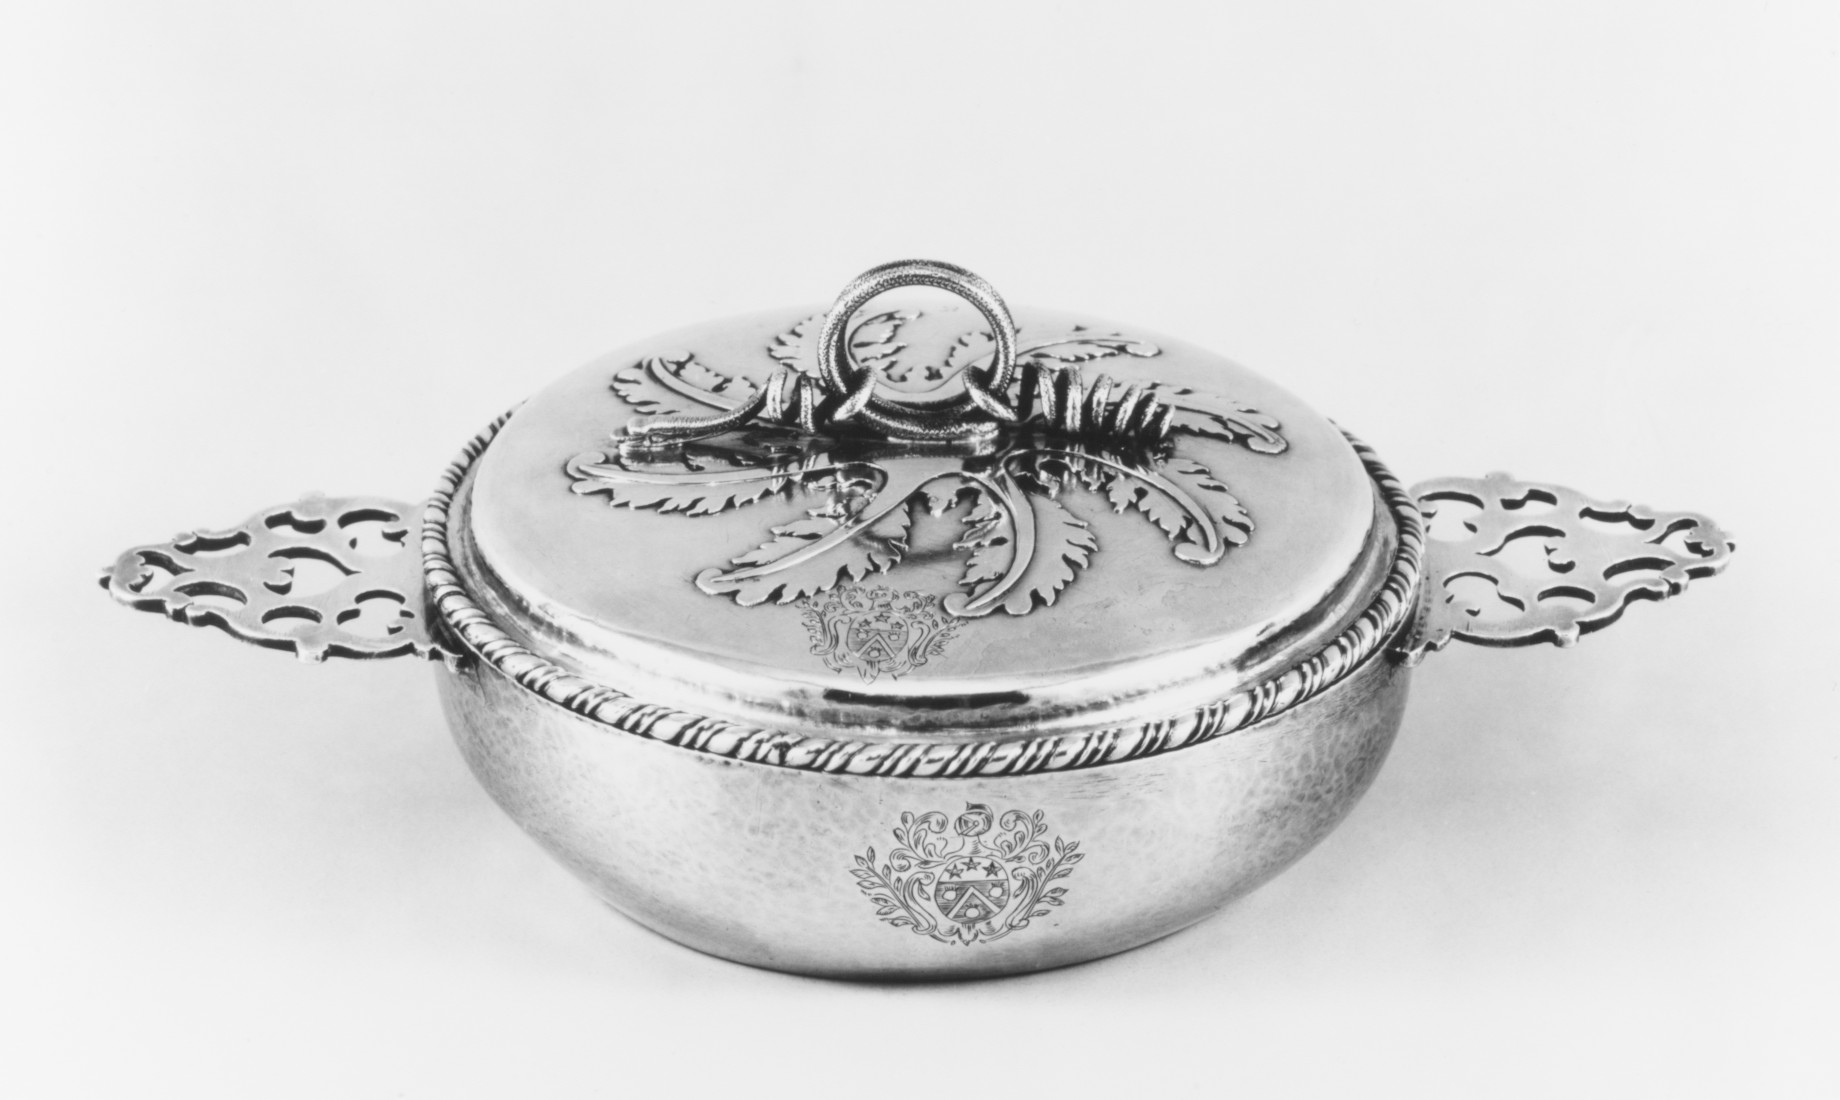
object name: bowl with cover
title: Bowl with cover (Écuelle)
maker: l.g.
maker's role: maker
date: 1681-1682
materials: silver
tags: coat of arms